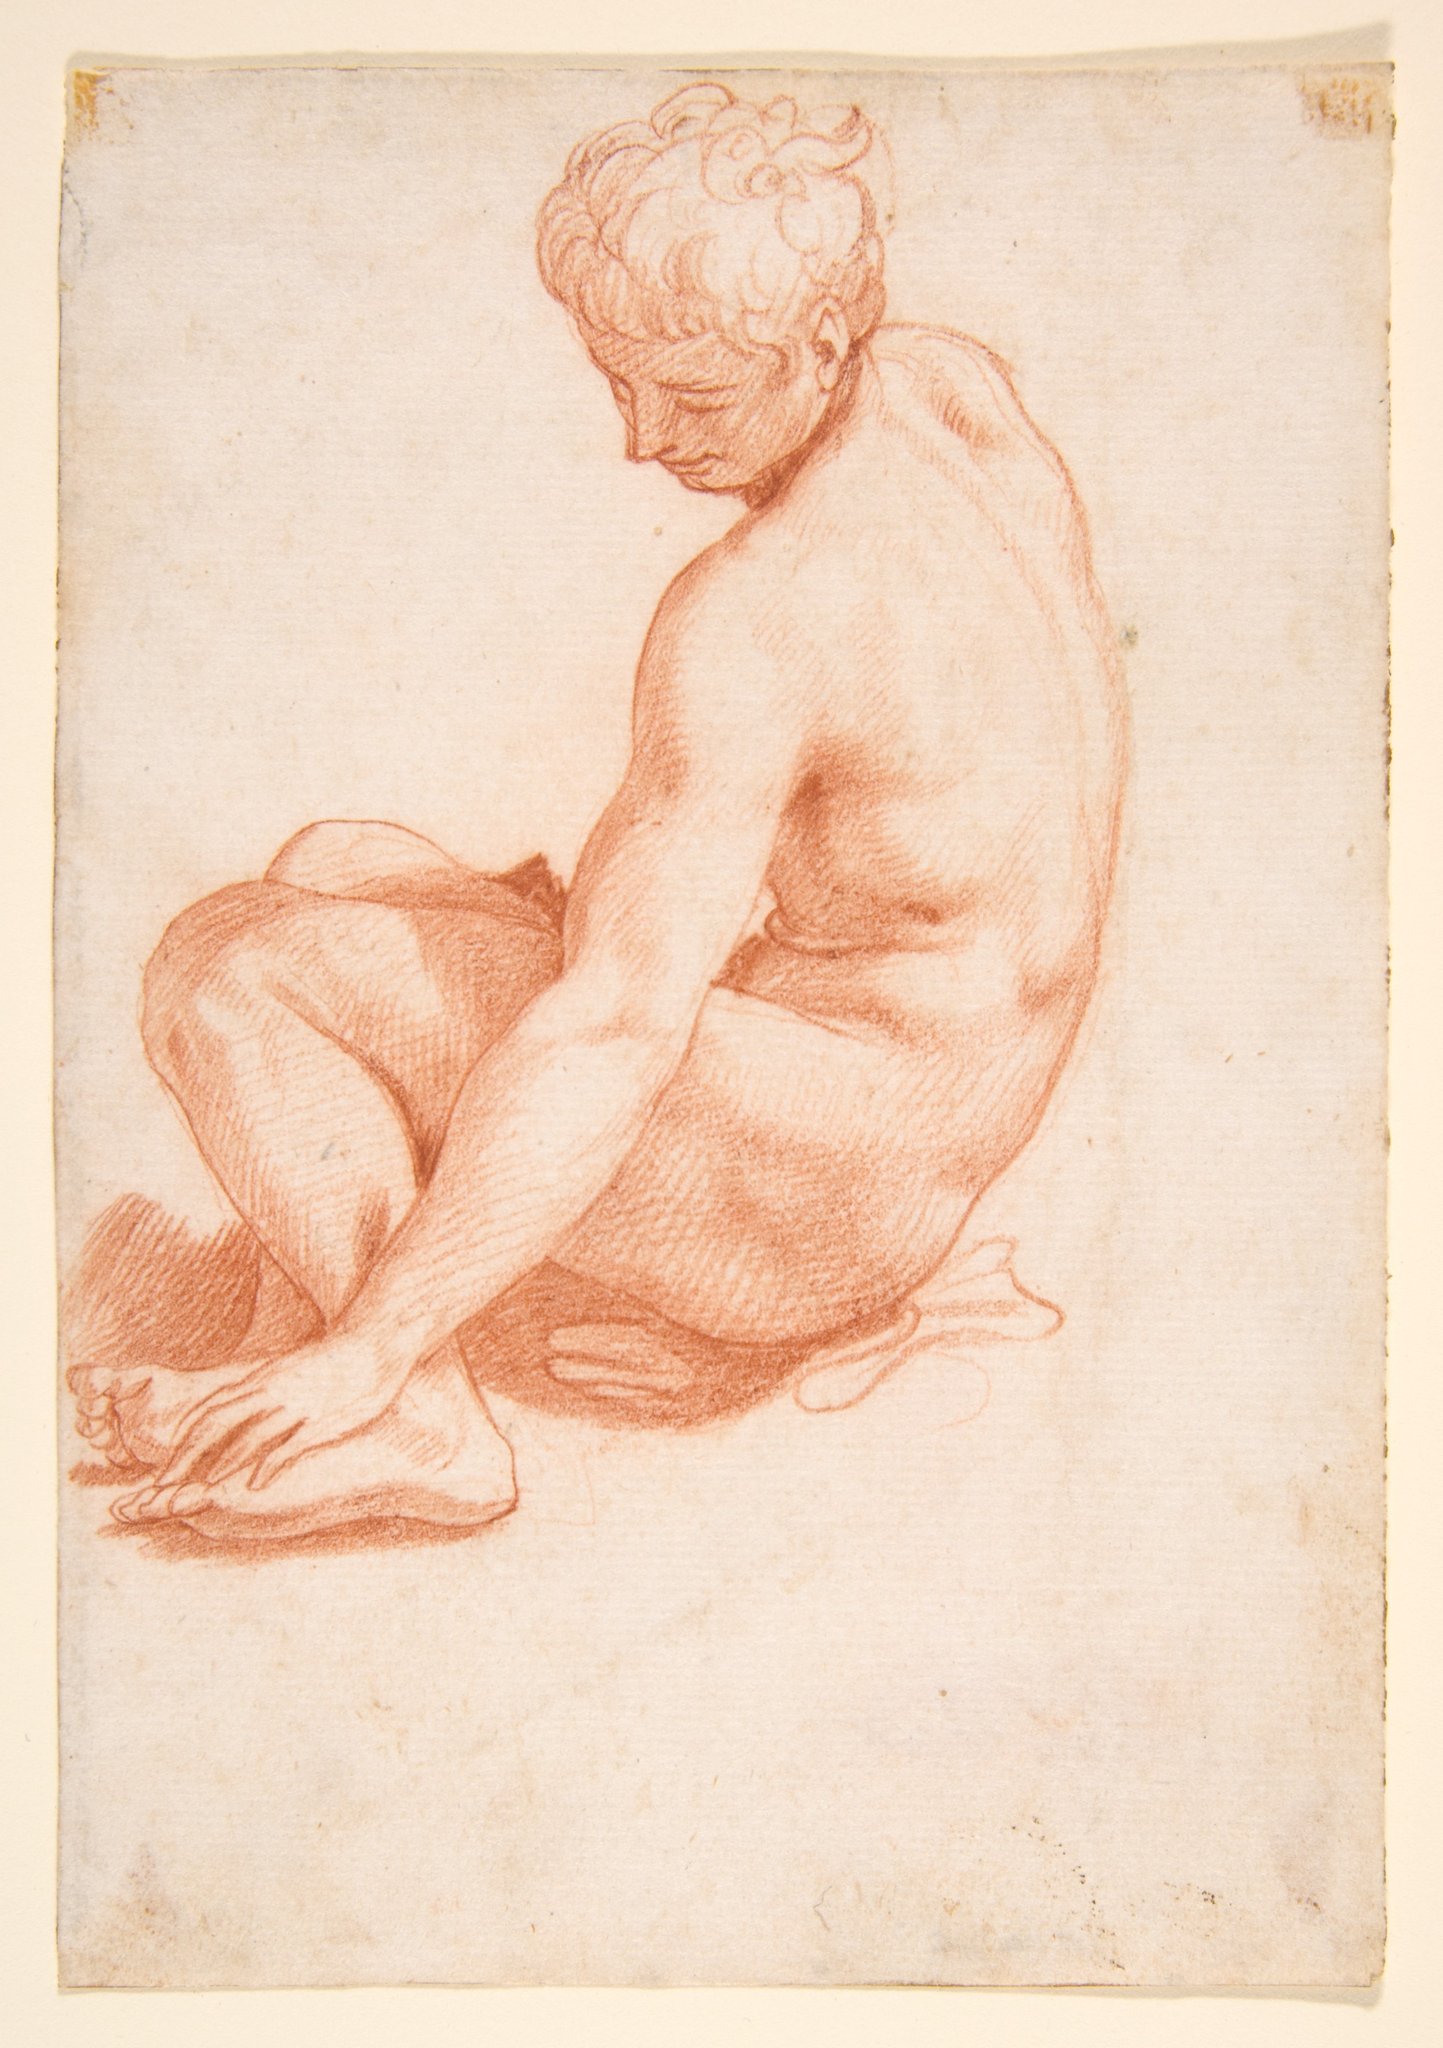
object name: drawing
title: Seated Male Nude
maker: francesco salviati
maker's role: artist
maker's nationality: italian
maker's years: 1510-1563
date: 1510-1563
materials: chalk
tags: male nudes